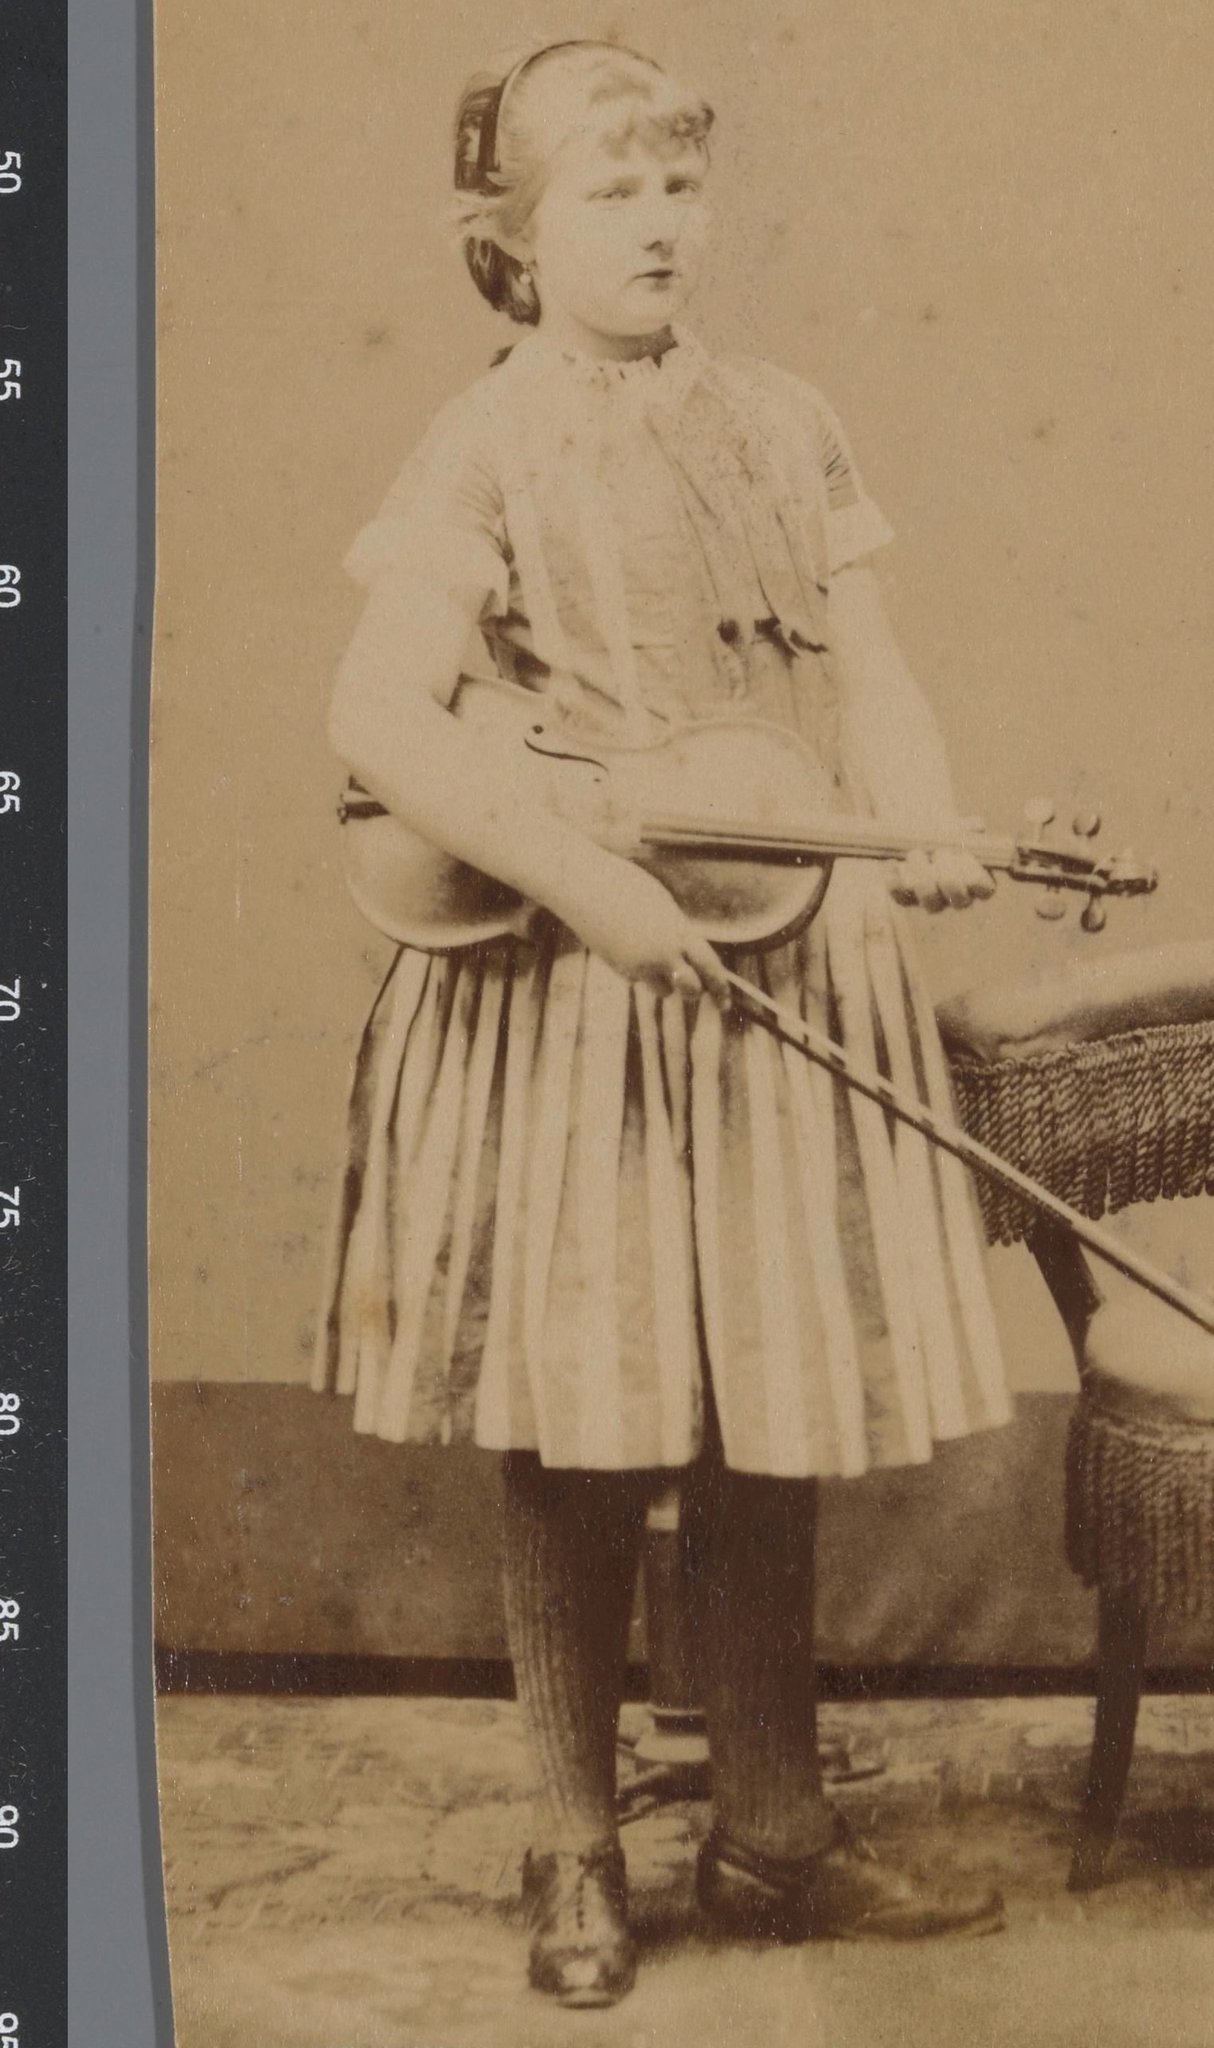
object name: photograph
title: Studioportret van een onbekend meisje met een viool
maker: Anonymous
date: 1875-1895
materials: cardboard, photographic support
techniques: albumen print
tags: violin, fiddle, girl (child between toddler and youth)